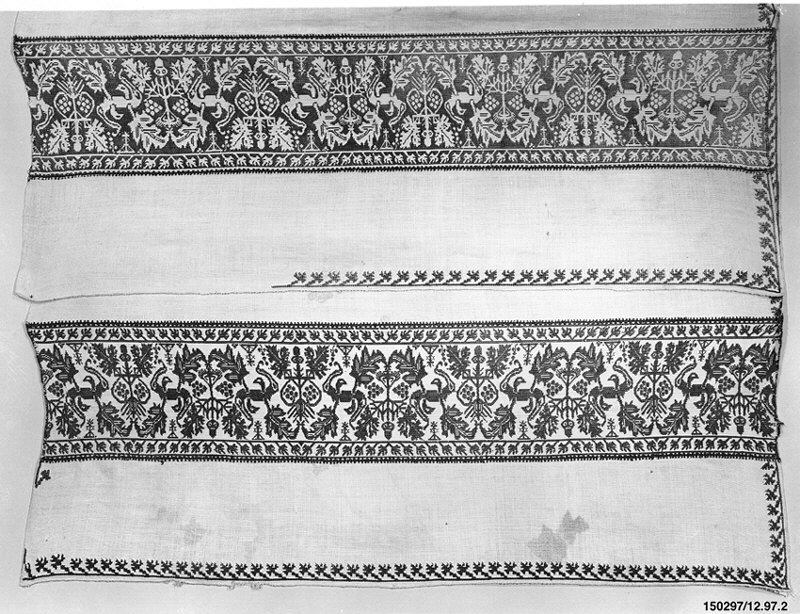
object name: towel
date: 1601-1700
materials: linen, silk